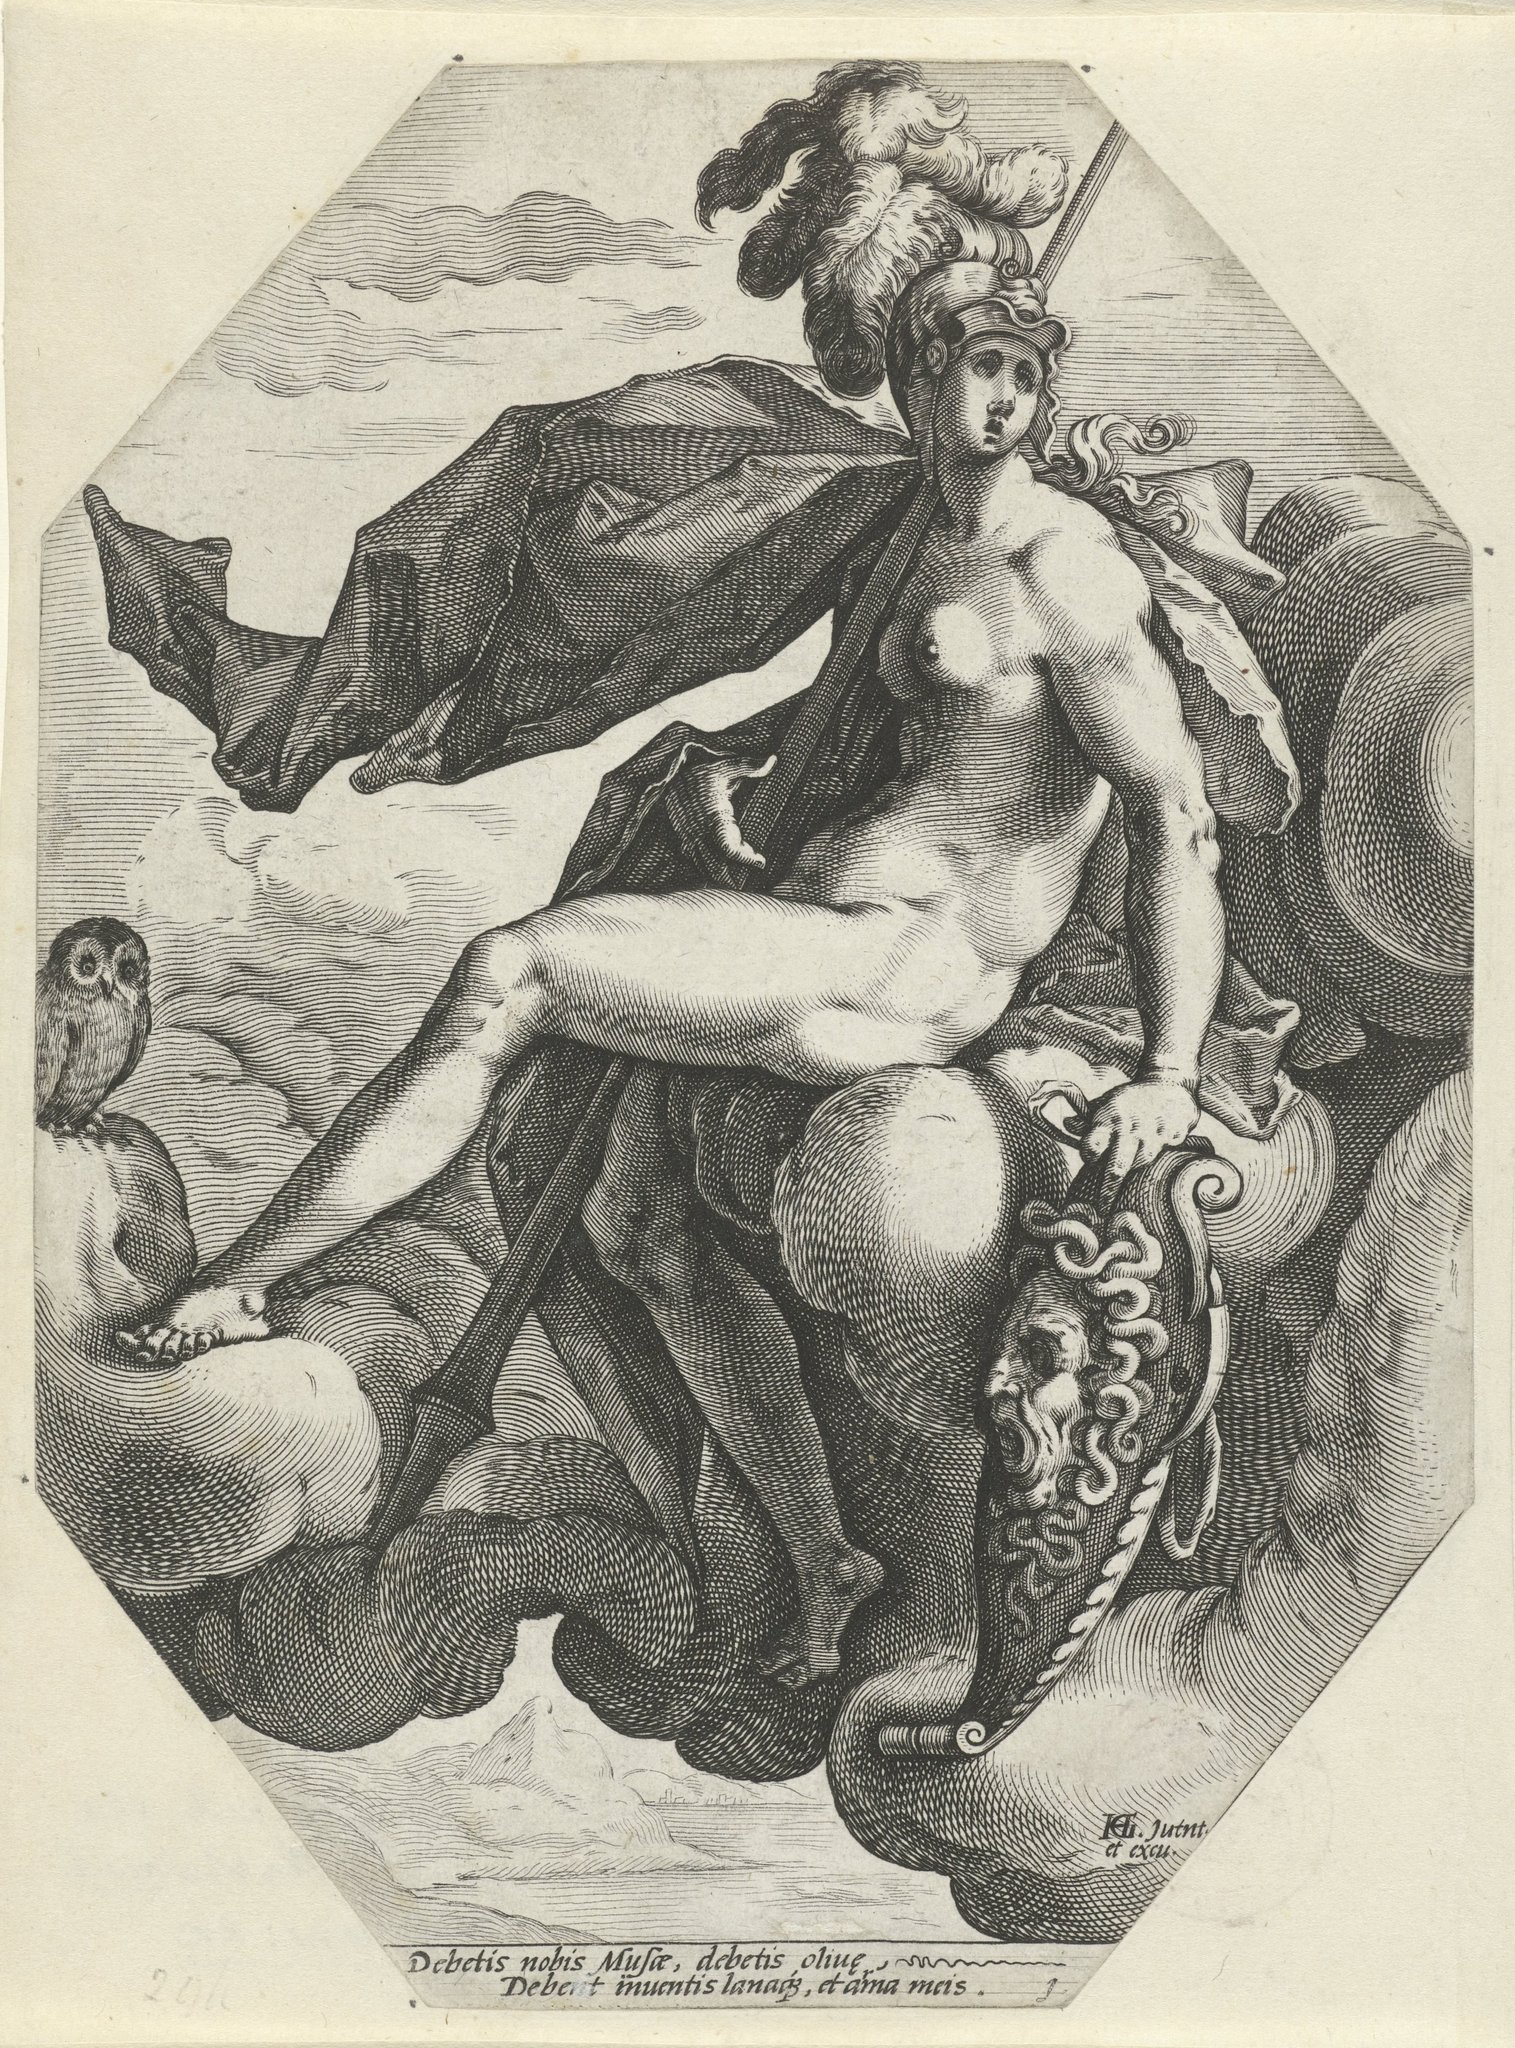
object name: print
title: Minerva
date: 1585-1589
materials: paper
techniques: engraving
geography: haarlem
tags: (story of) minerva (pallas, athena)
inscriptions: collector's mark: Lugt 240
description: De godin Minerva, zittend op een wolk. Zij draagt een helm, heeft een speer en een schild vast en wordt vergezeld door haar attribuut: de uil.